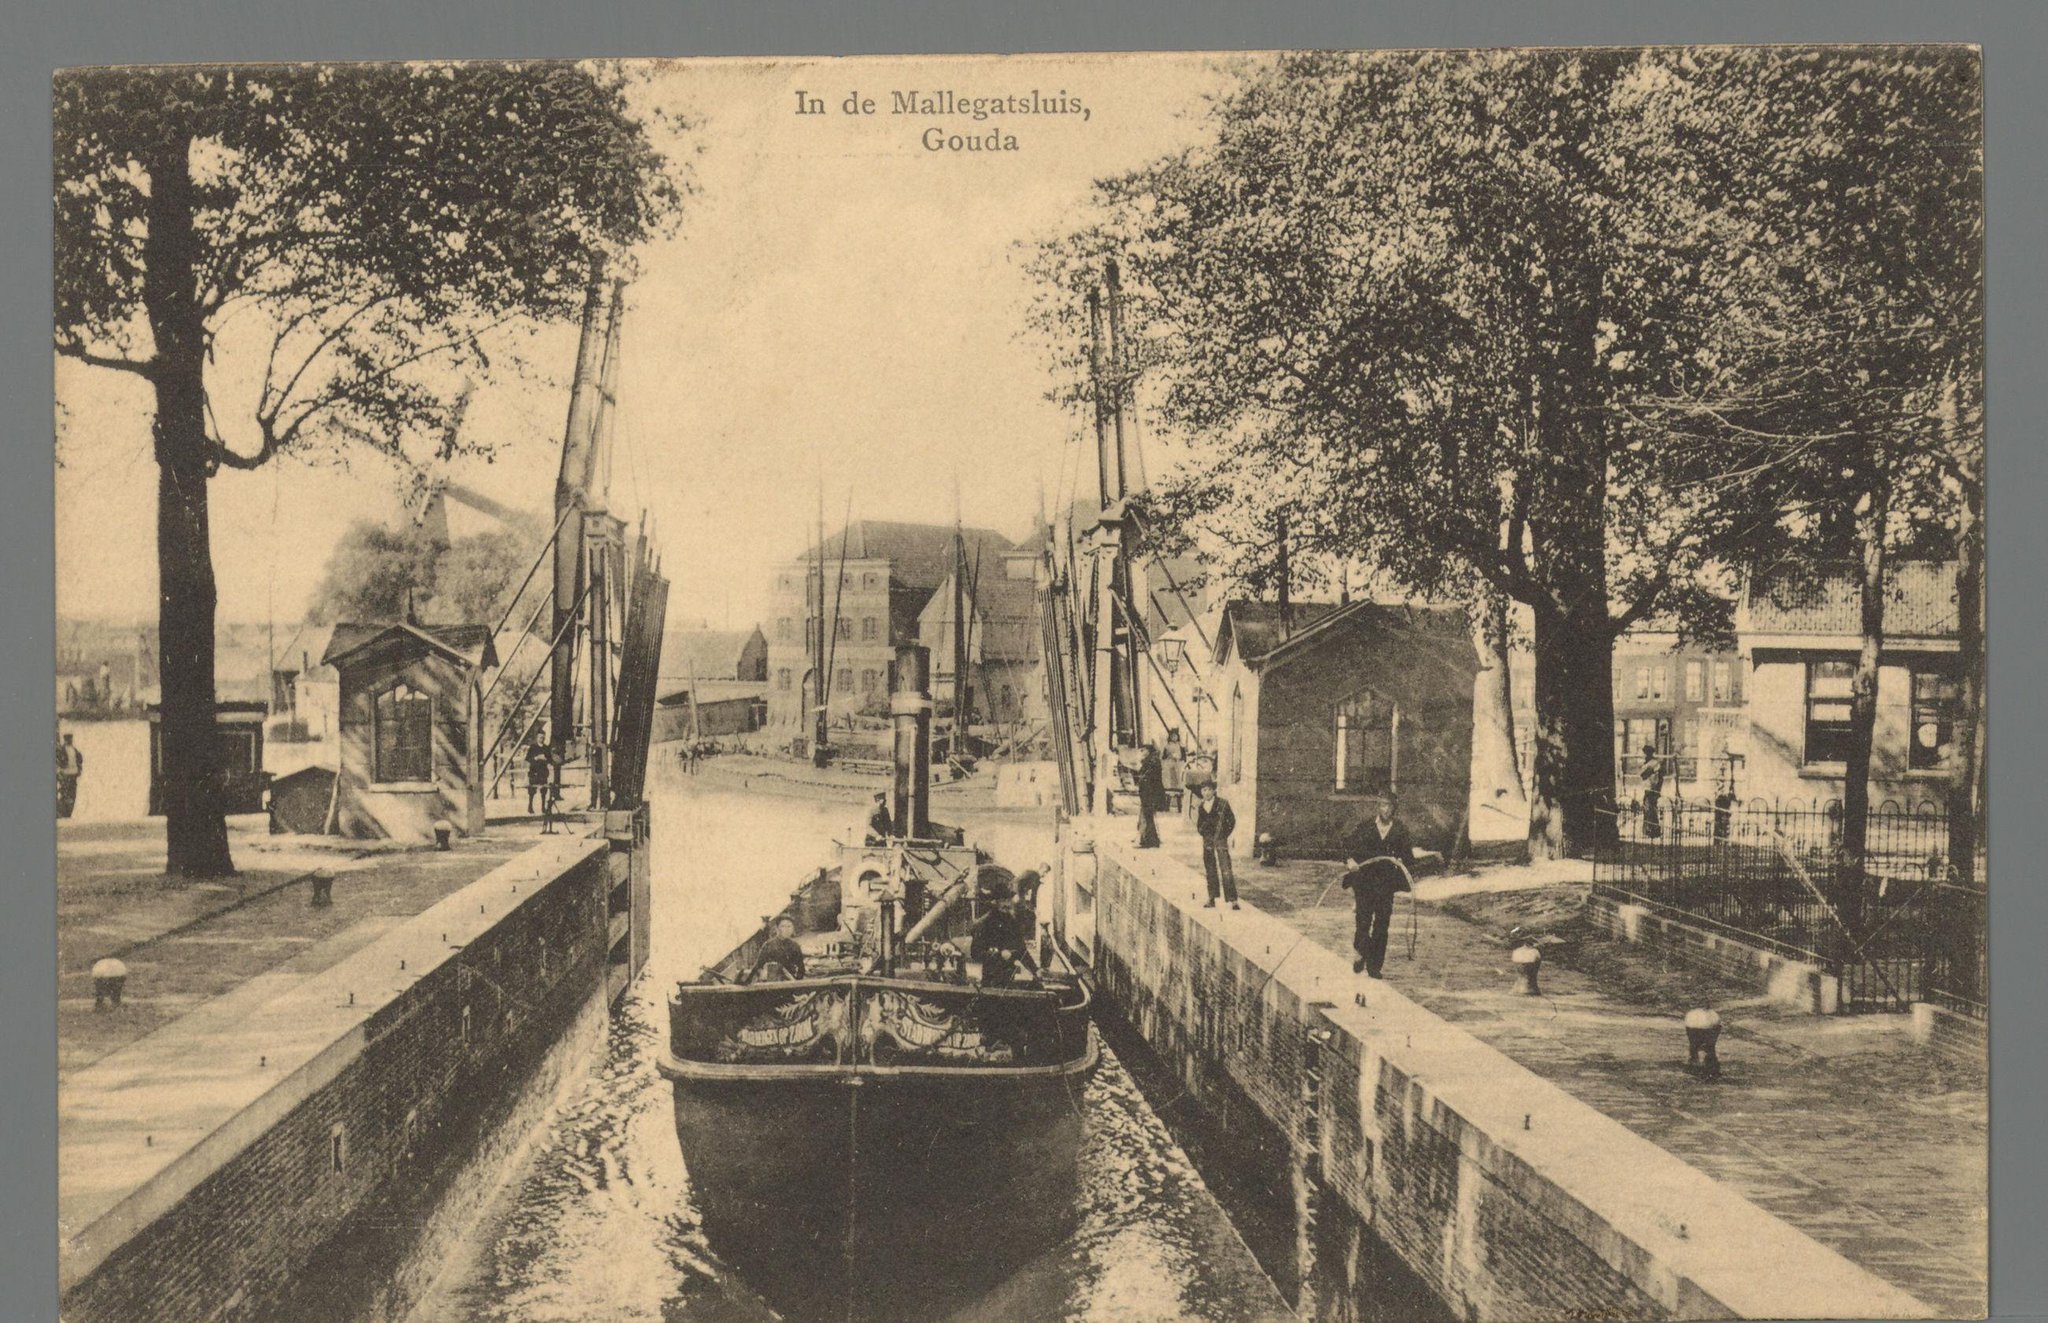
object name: ansichtkaart, prentbriefkaart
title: In de Mallegatsluis, Gouda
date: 1905-1930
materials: cardboard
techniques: photograph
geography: gouda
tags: lift-lock, canal lock, bridge in village across river, canal, etc., steamship, motorship, gouda